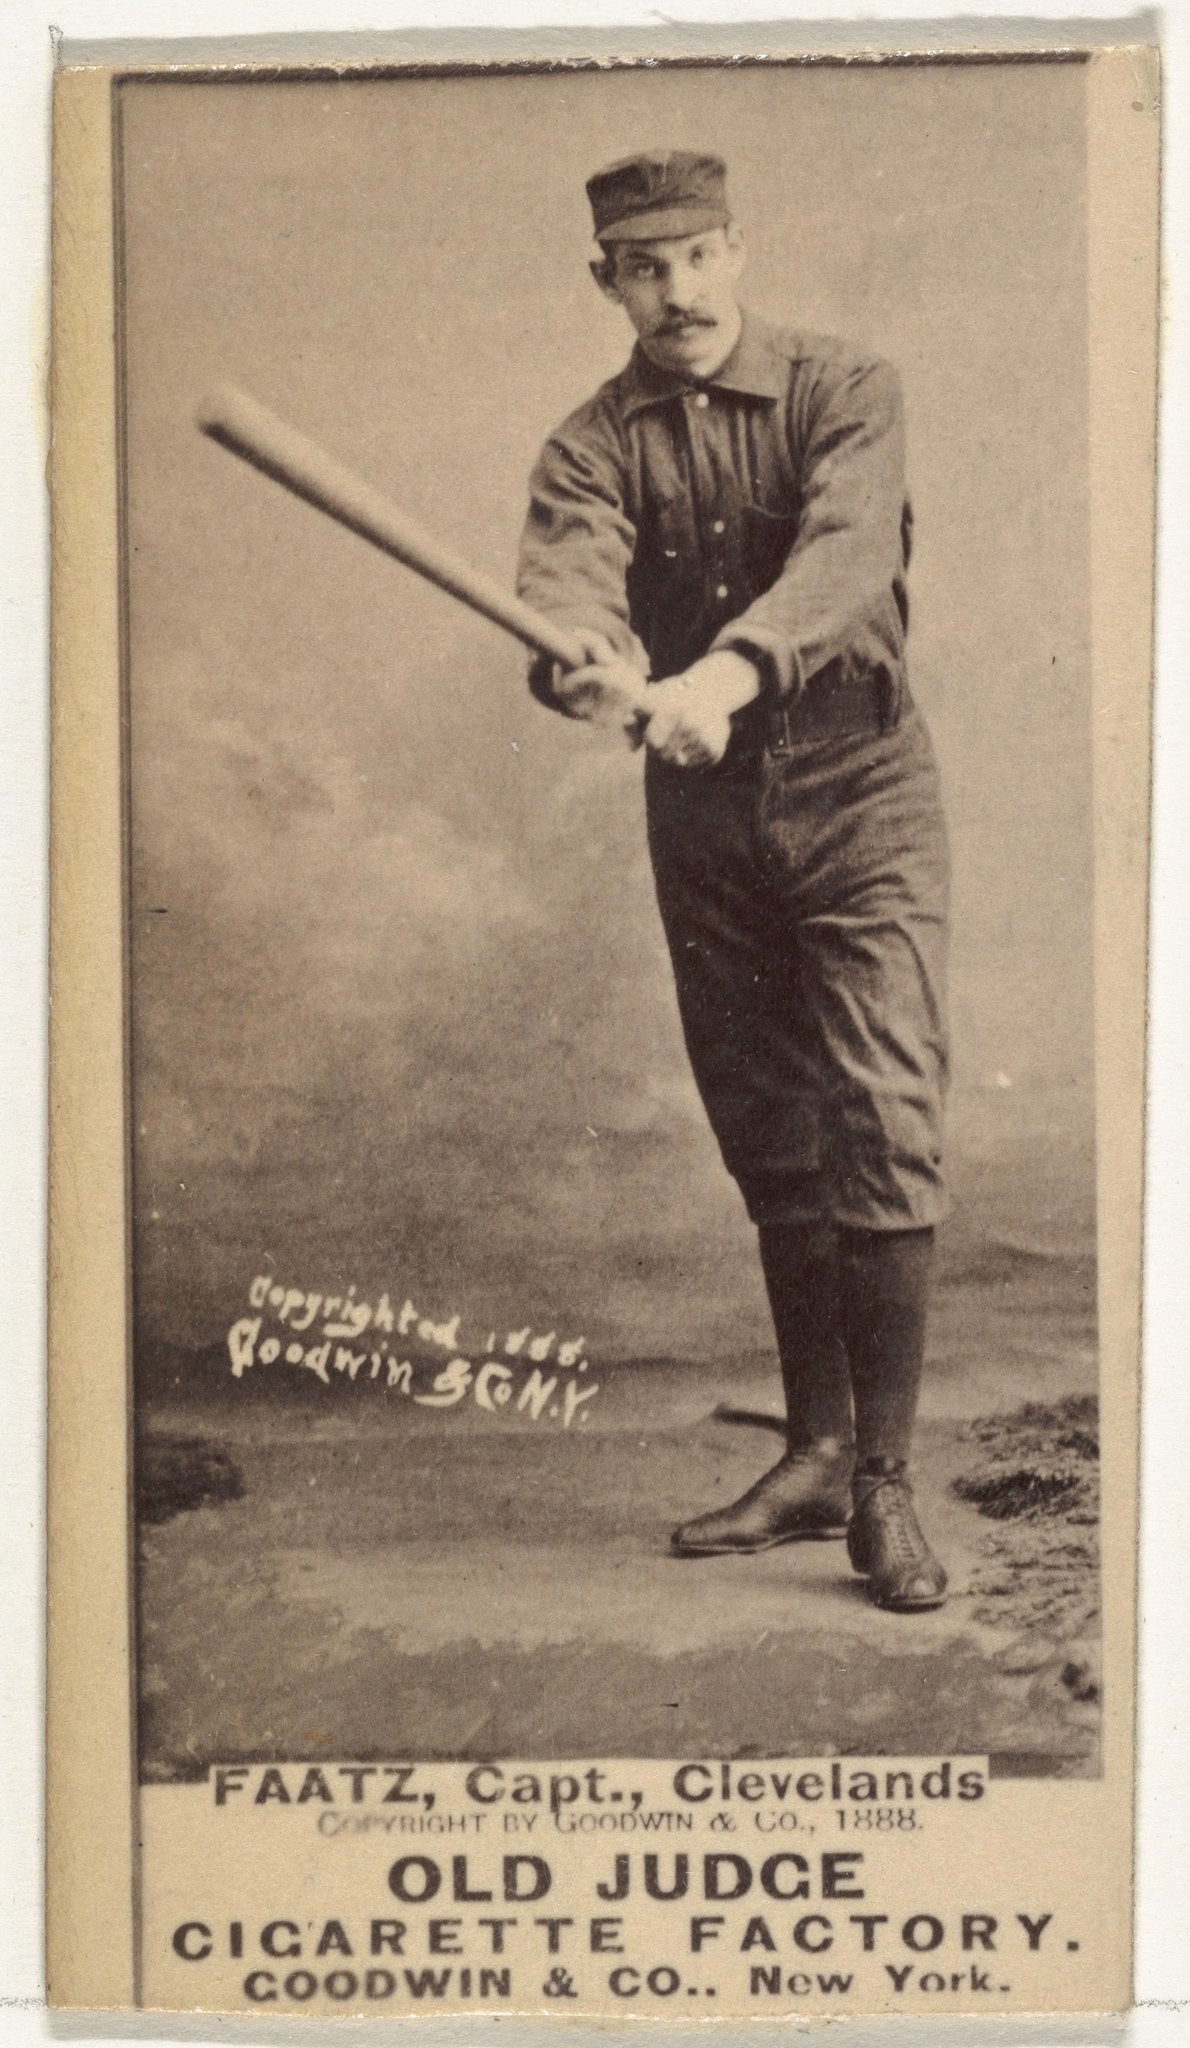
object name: baseball card, photograph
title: Jayson S. "Jay" Faatz, Captain, Cleveland, from the Old Judge series (N172) for Old Judge Cigarettes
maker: goodwin & company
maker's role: publisher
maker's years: 1850-1950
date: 1888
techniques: albumen silver print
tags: men,portraits,baseball,athletes